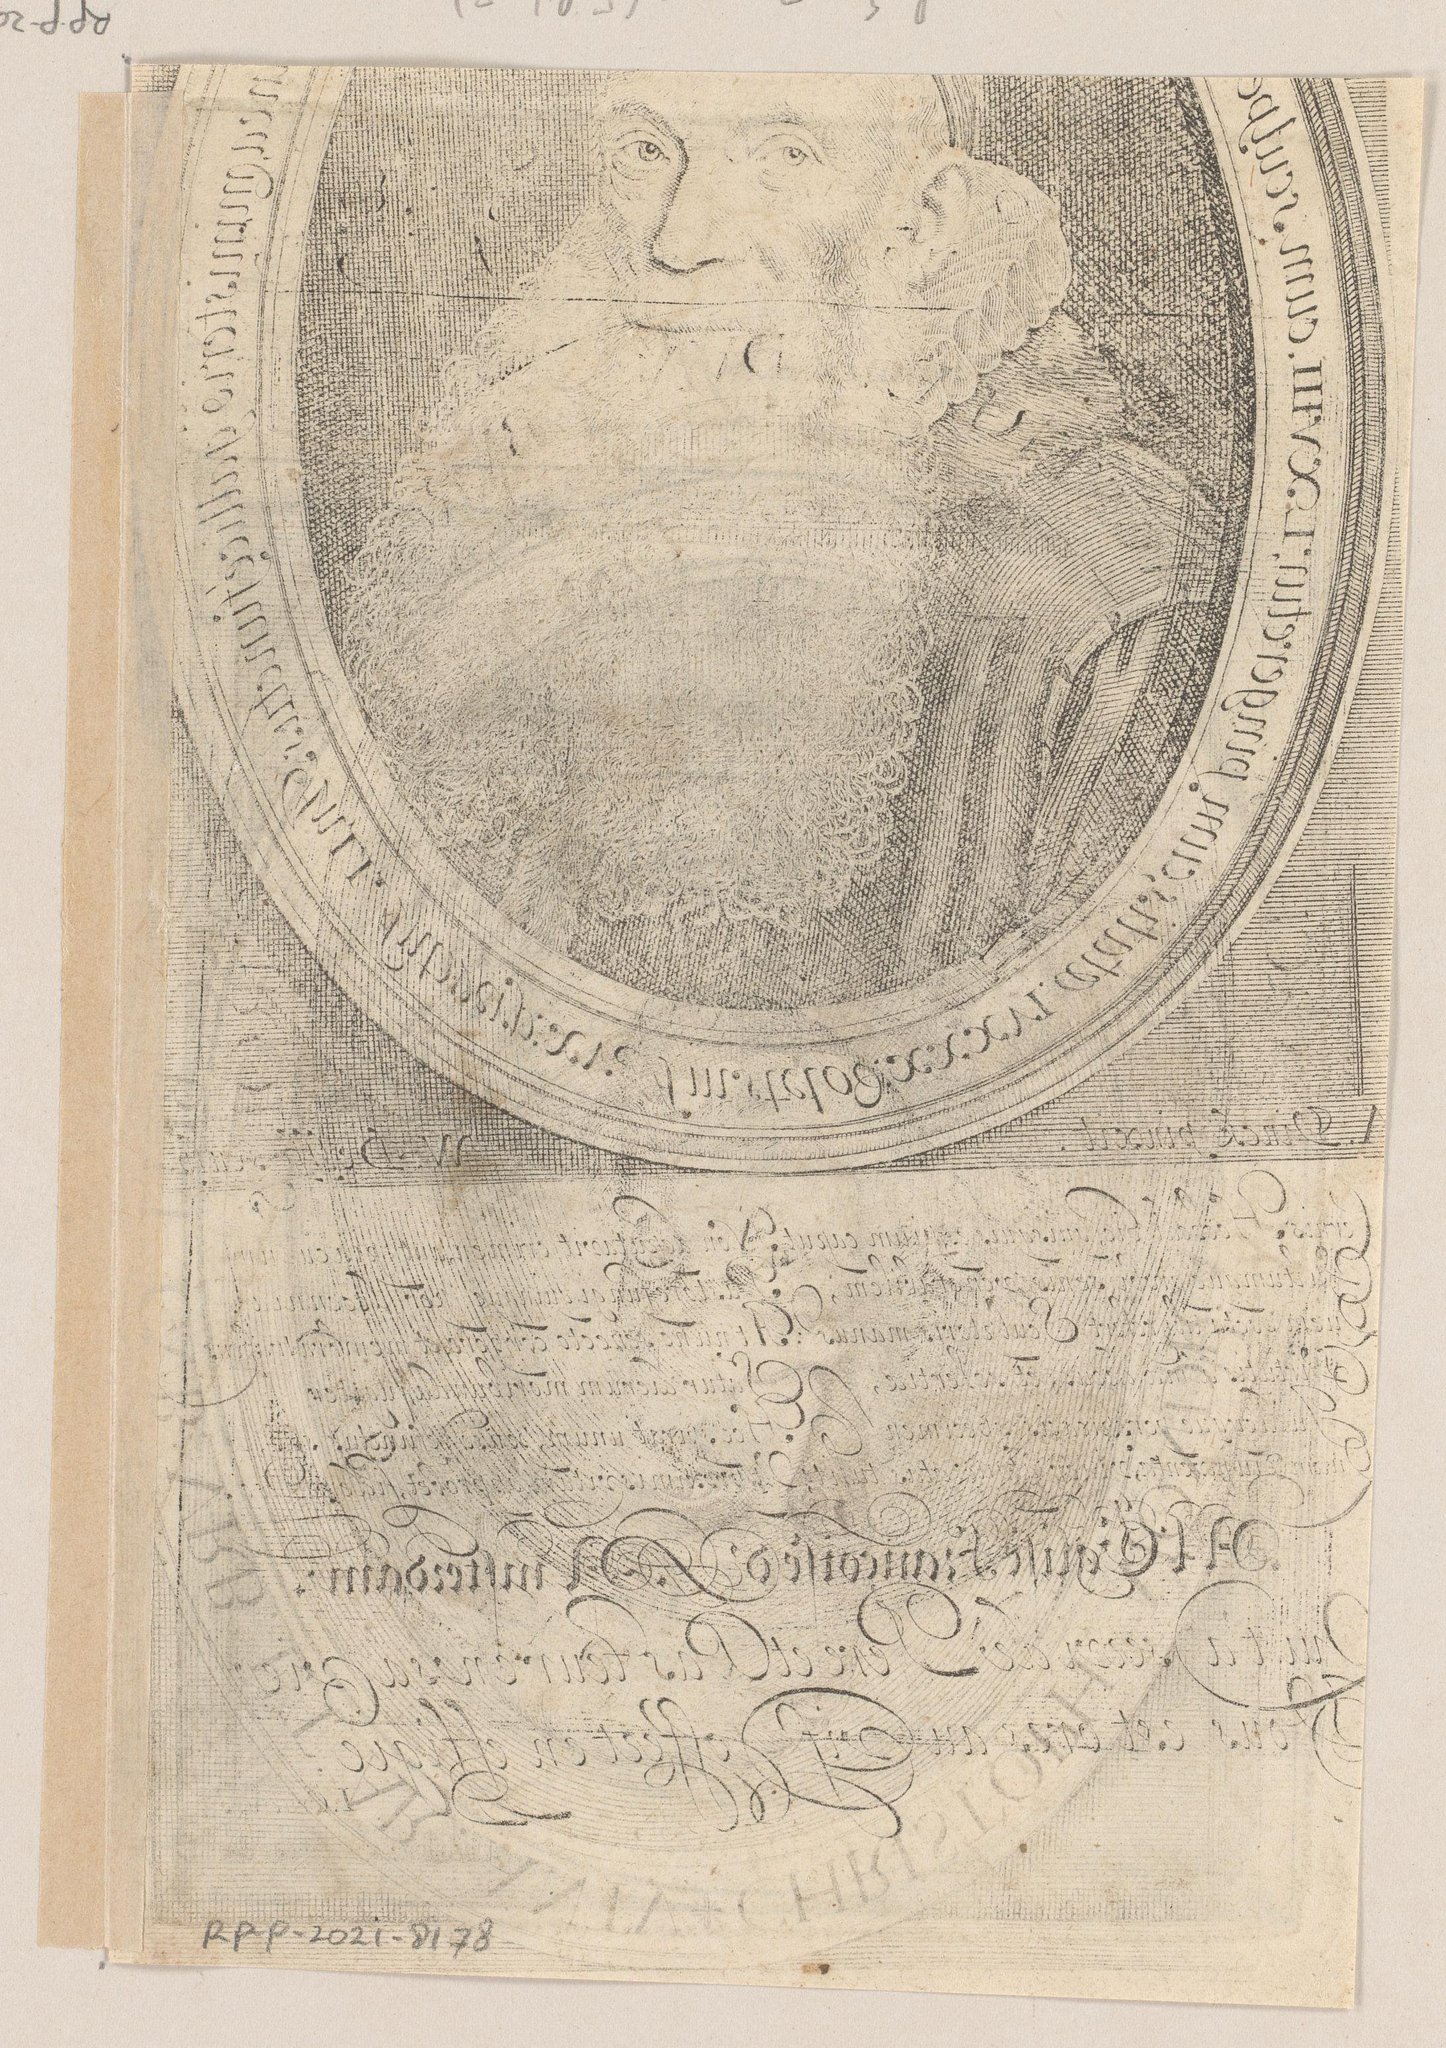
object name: print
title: Portret van Johannes Hochedaeus op 80-jarige leeftijd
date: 1622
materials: paper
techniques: printmaking, engraving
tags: amsterdam, historical persons